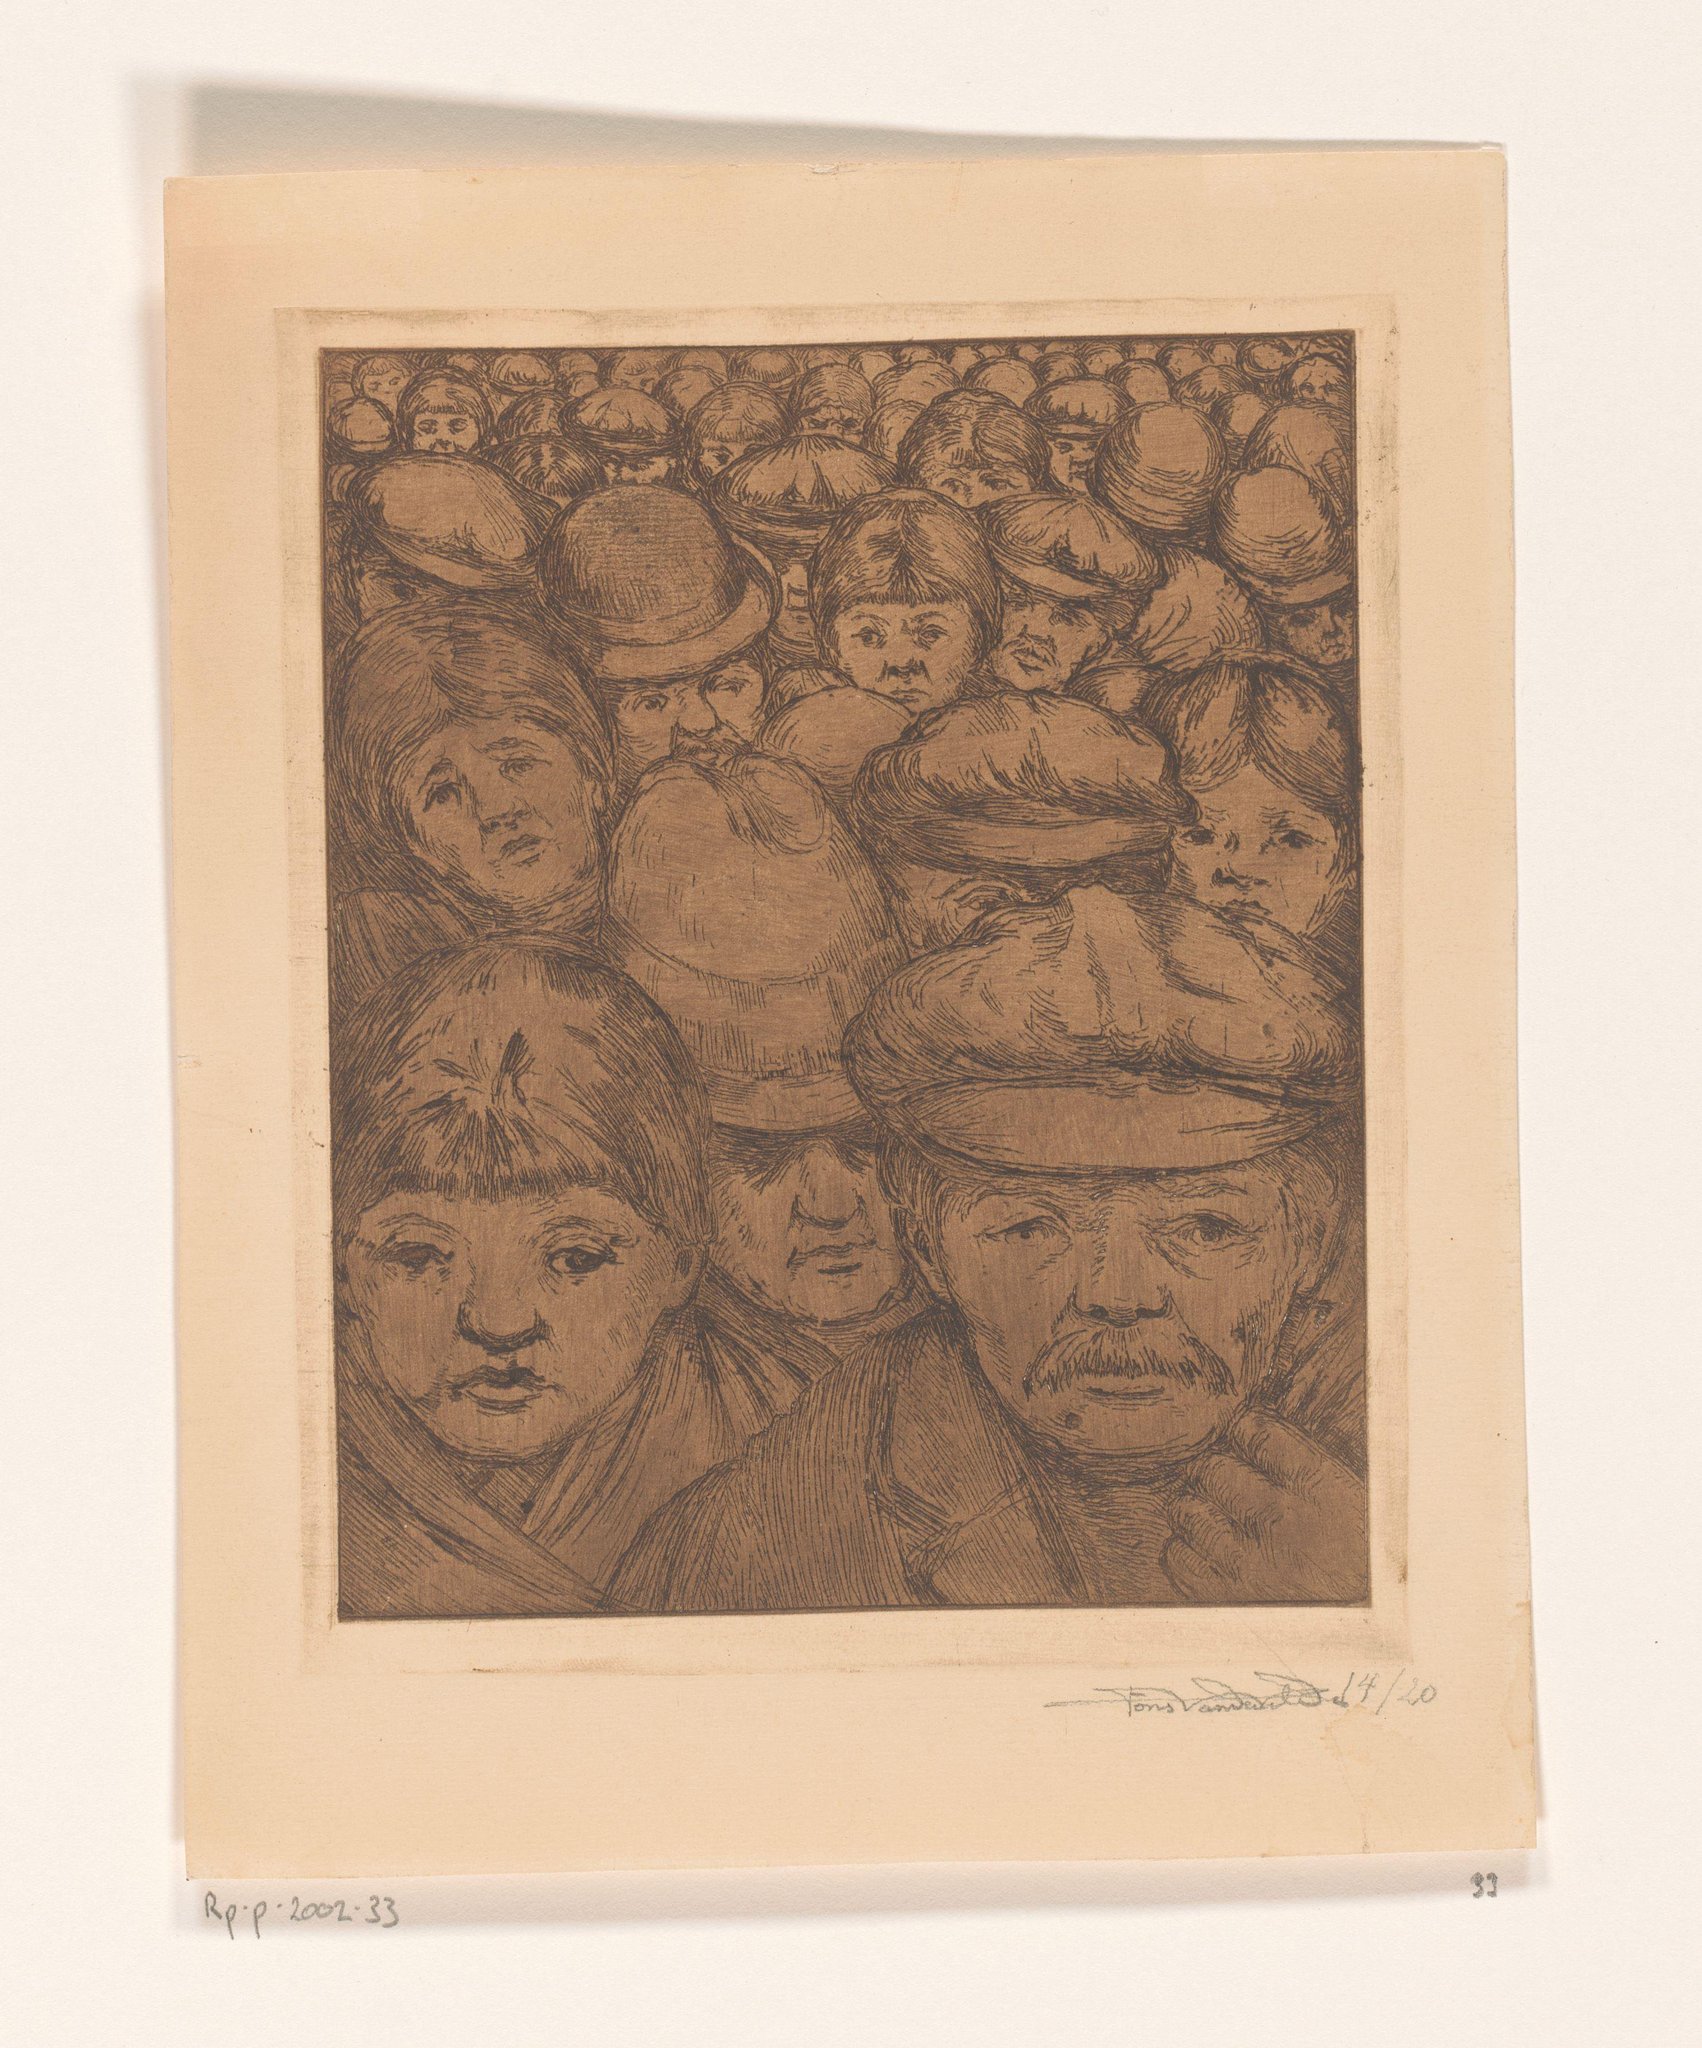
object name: print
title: Koppen in een menigte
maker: fons van der velde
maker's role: print maker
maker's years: 1870-1936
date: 1880-1936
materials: paper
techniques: drypoint, etching, intaglio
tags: crowd, mob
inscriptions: collector's mark: Lugt 2228, collector's mark: Lugt 2760, collector's mark: ‘qJh’